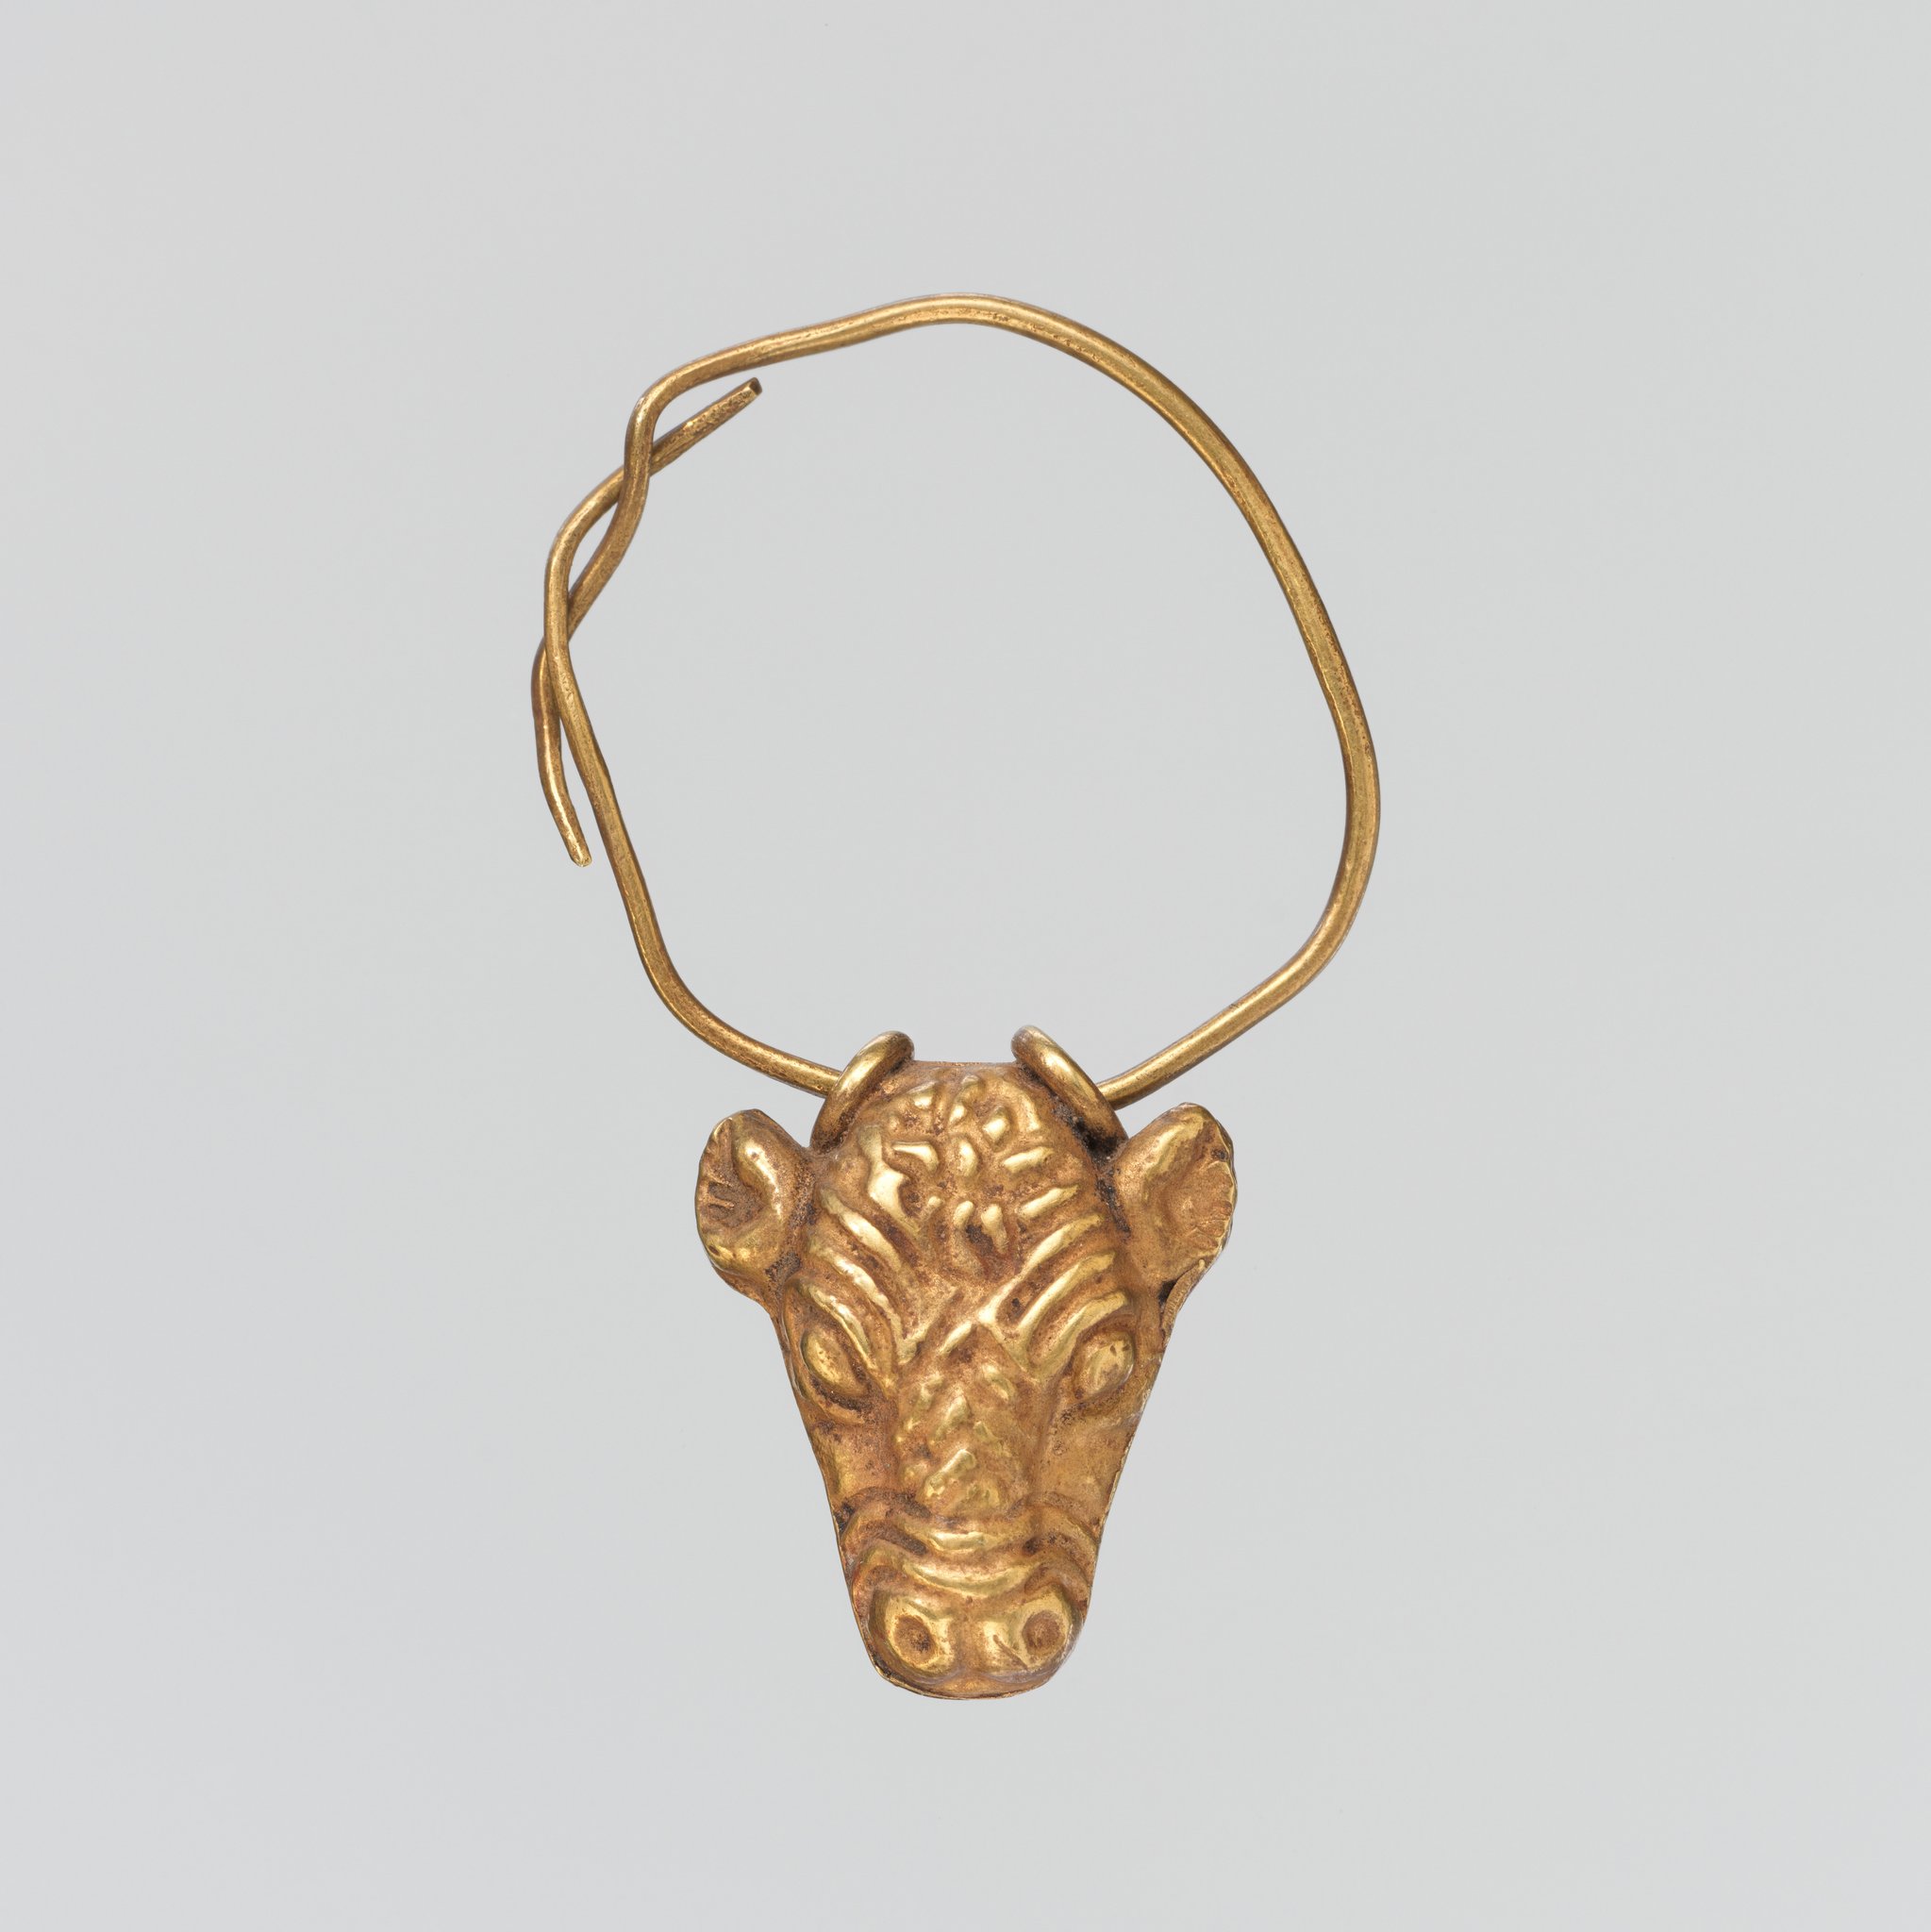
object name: earring with head of bull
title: Gold earring with head of a bull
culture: cypriot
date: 1400-1050 BCE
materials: gold